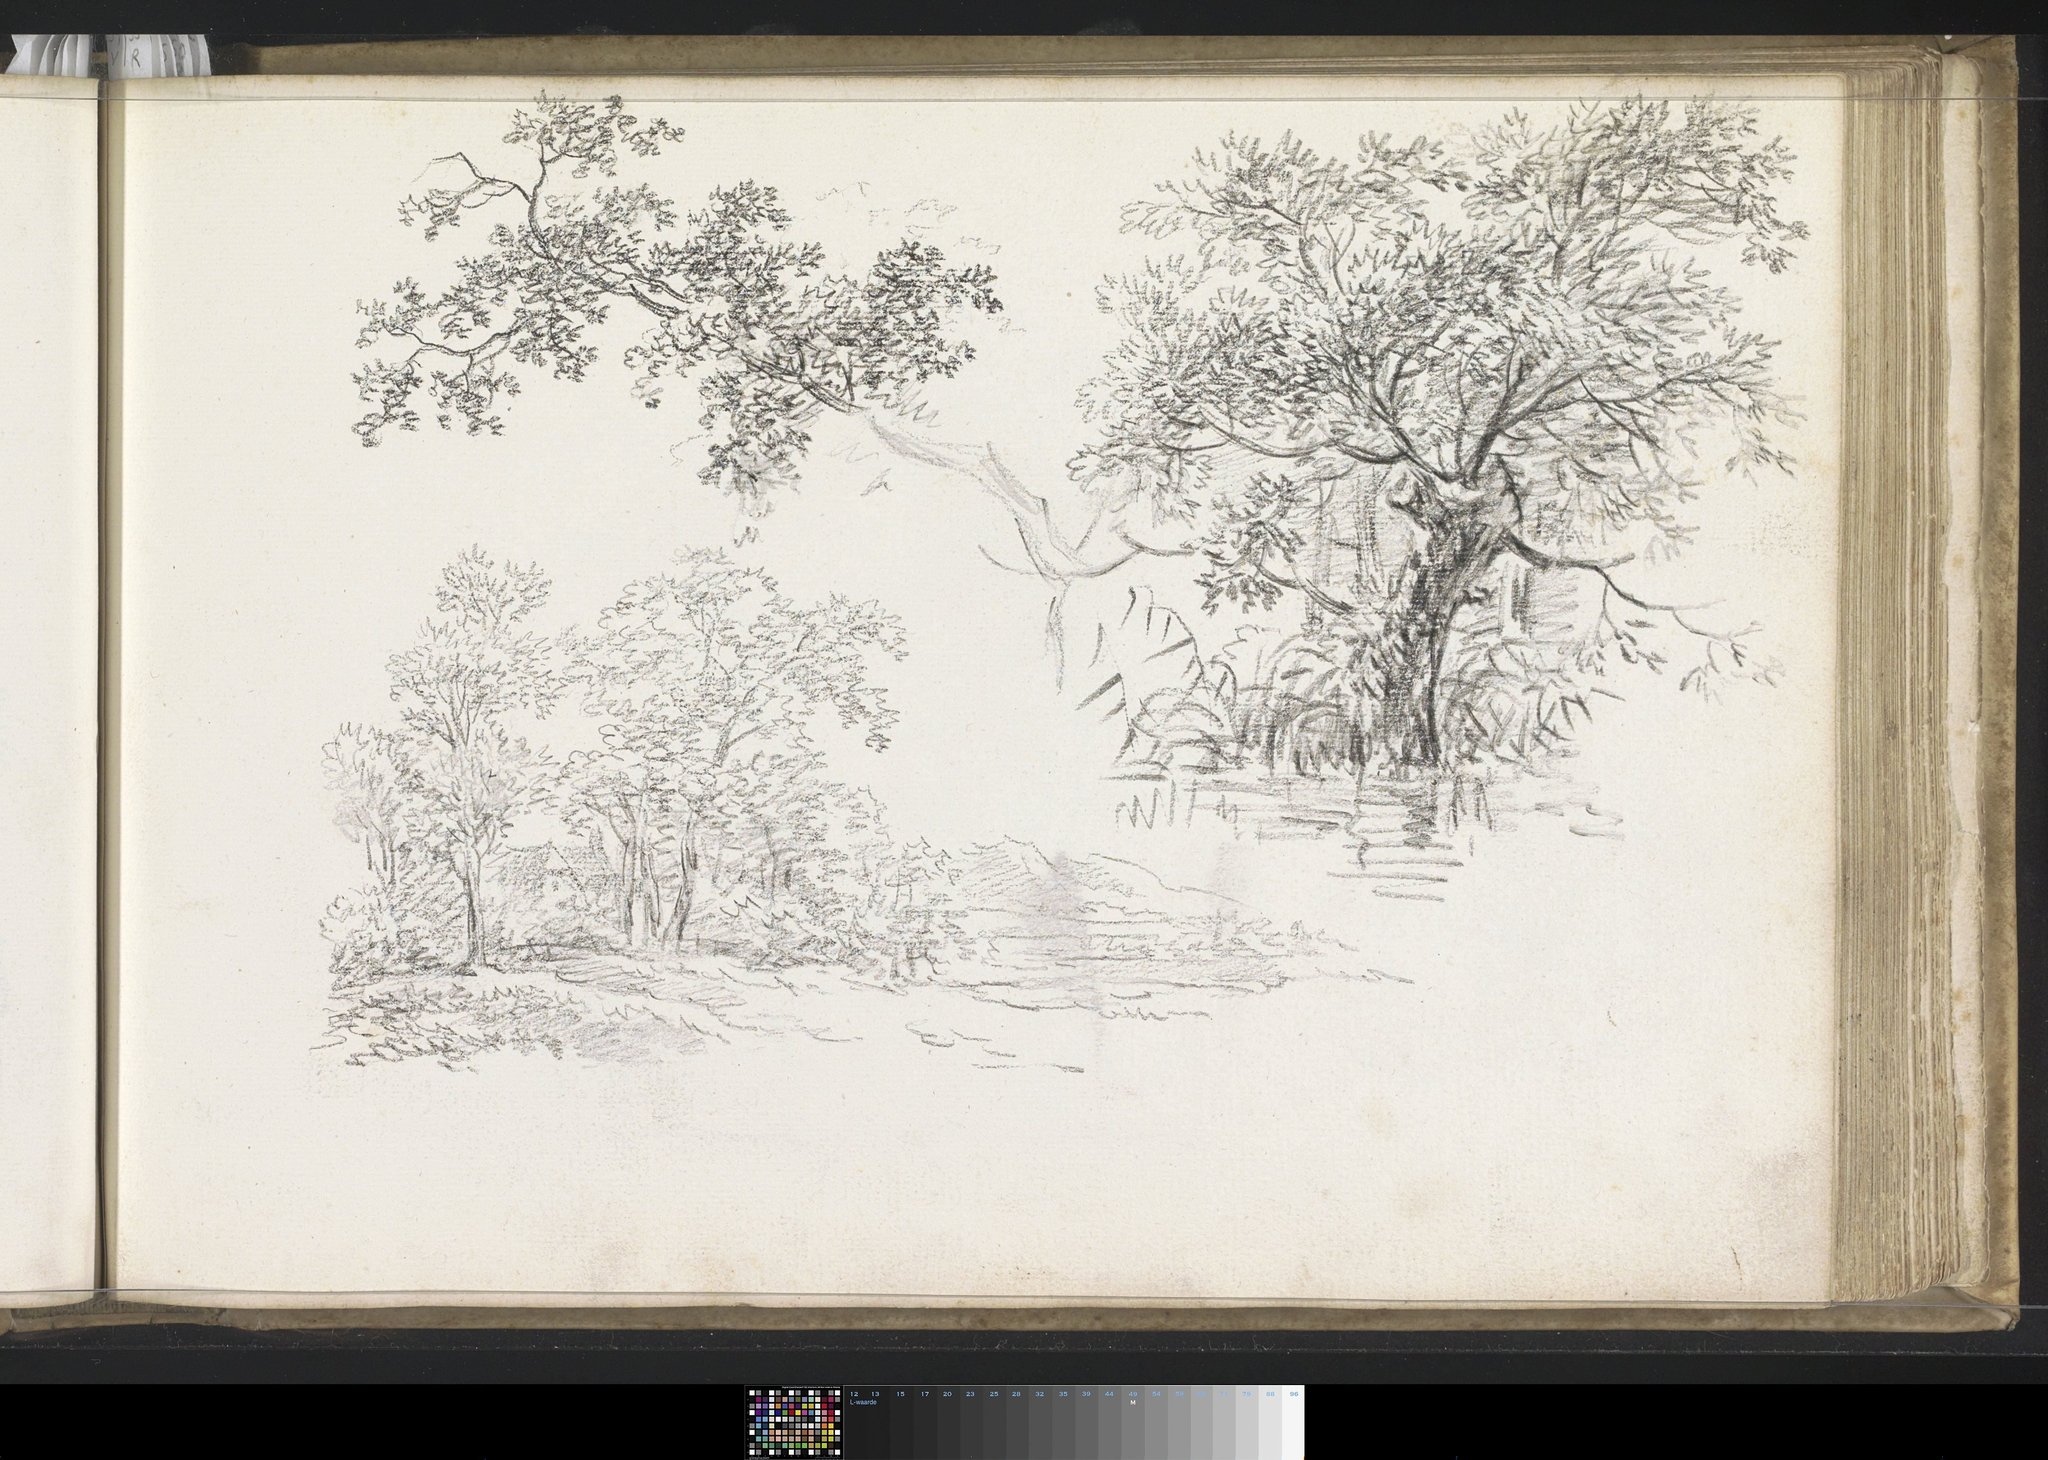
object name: sketchbook leaf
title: Landschap, tak met bladeren en een boom aan een waterkant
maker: andreas schelfhout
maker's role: draughtsman, painter, print maker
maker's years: 1787-1870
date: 1811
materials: chalk, paper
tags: trees (+ branch, stick), landscapes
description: Blad 34 recto uit een schetsboek met 75 bladen.